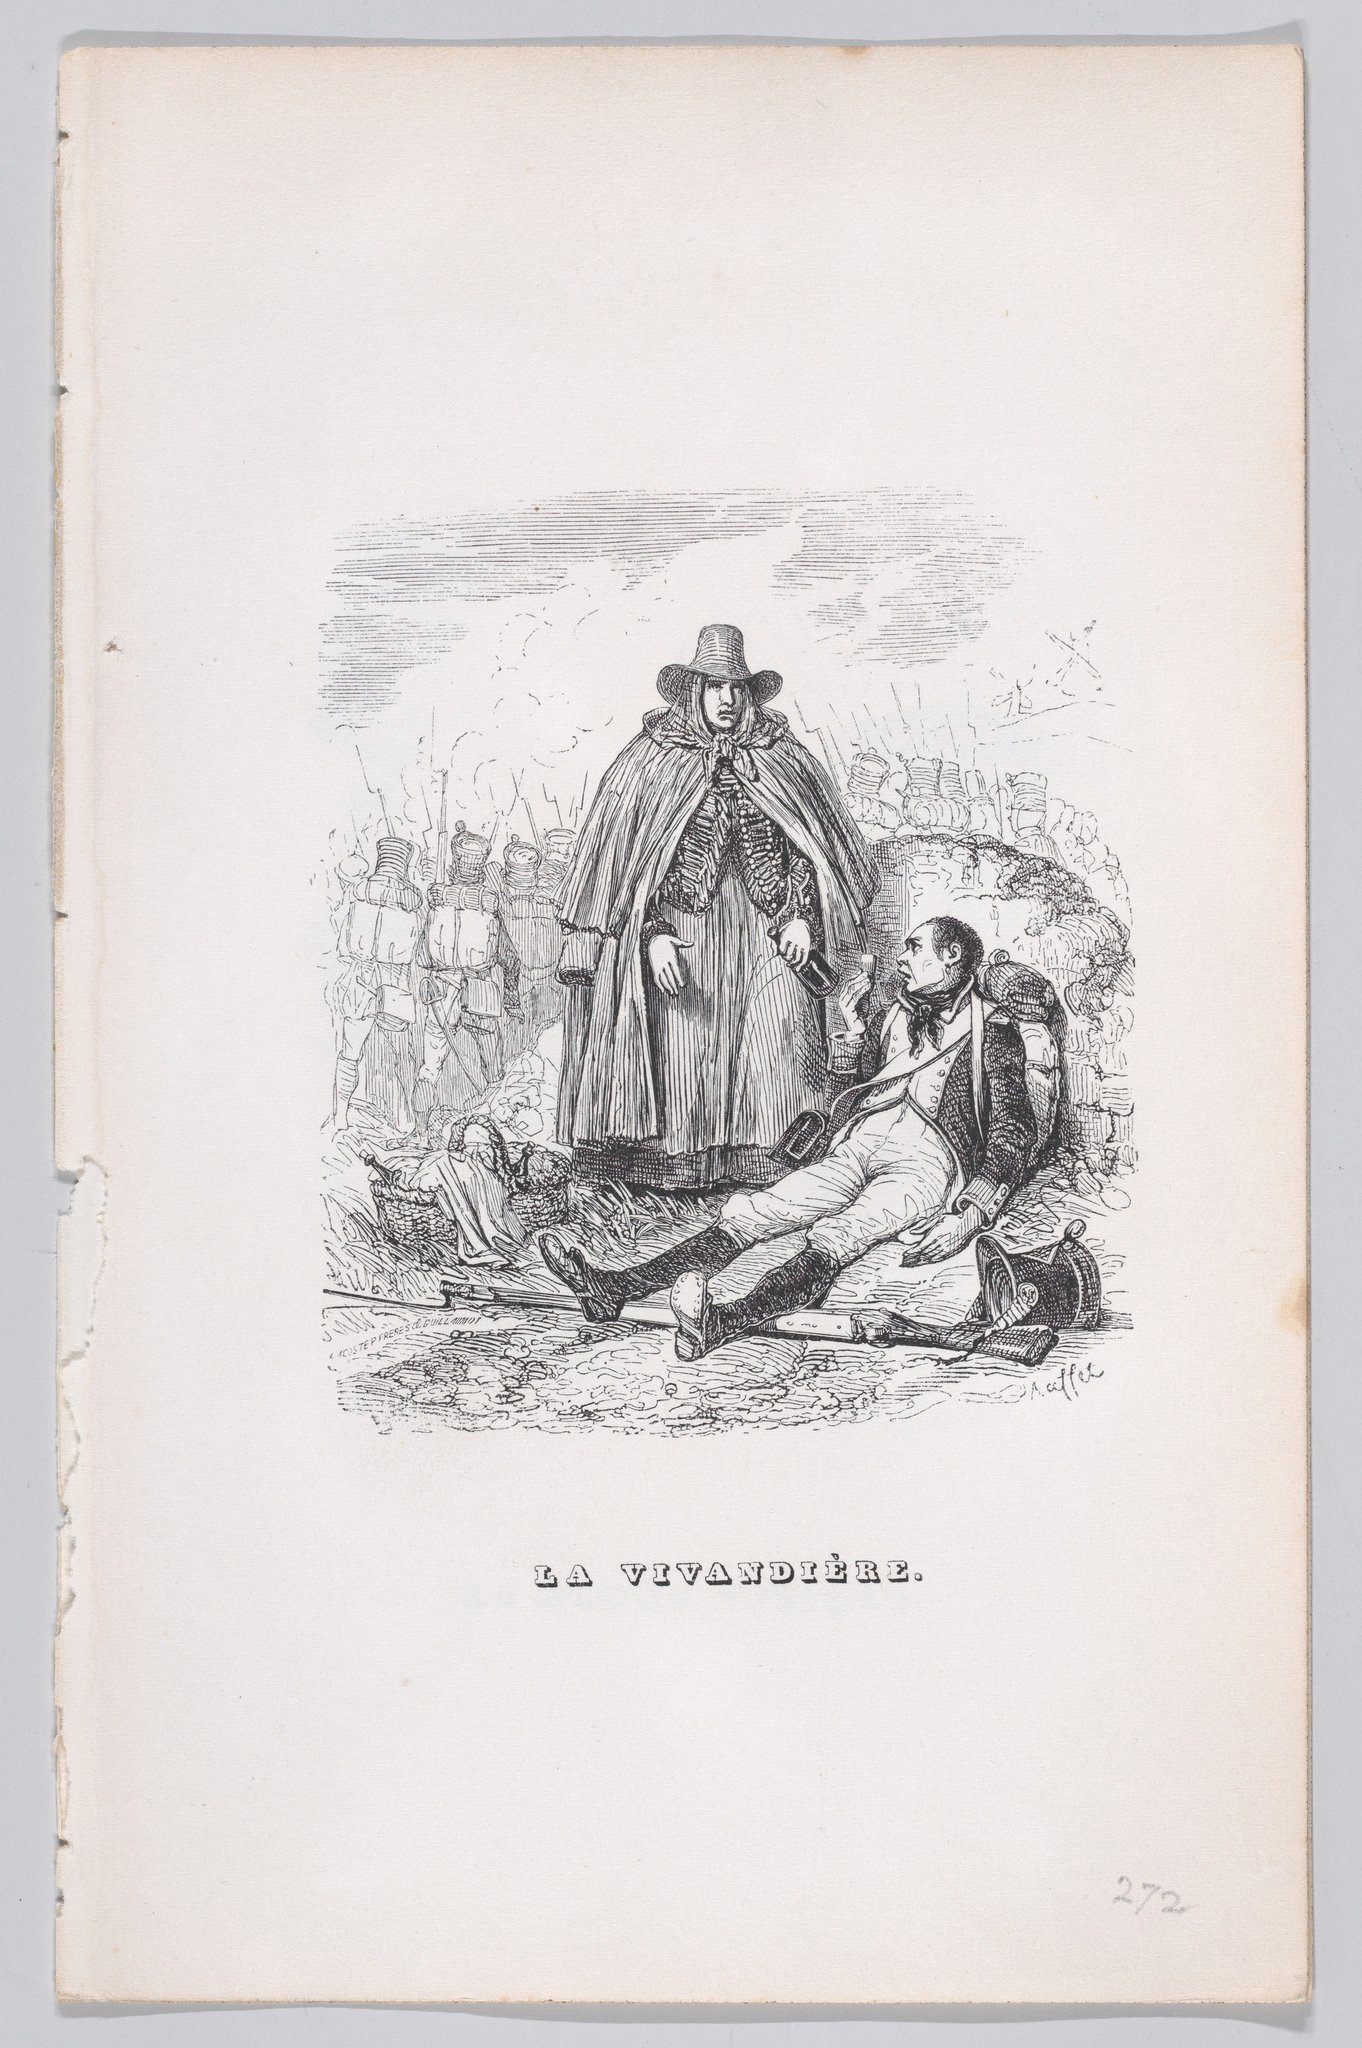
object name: print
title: The Vivandière, from "The Complete Works of Béranger"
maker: j. j. grandville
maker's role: illustrator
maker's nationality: french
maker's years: 1803-1847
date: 1836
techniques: engraving